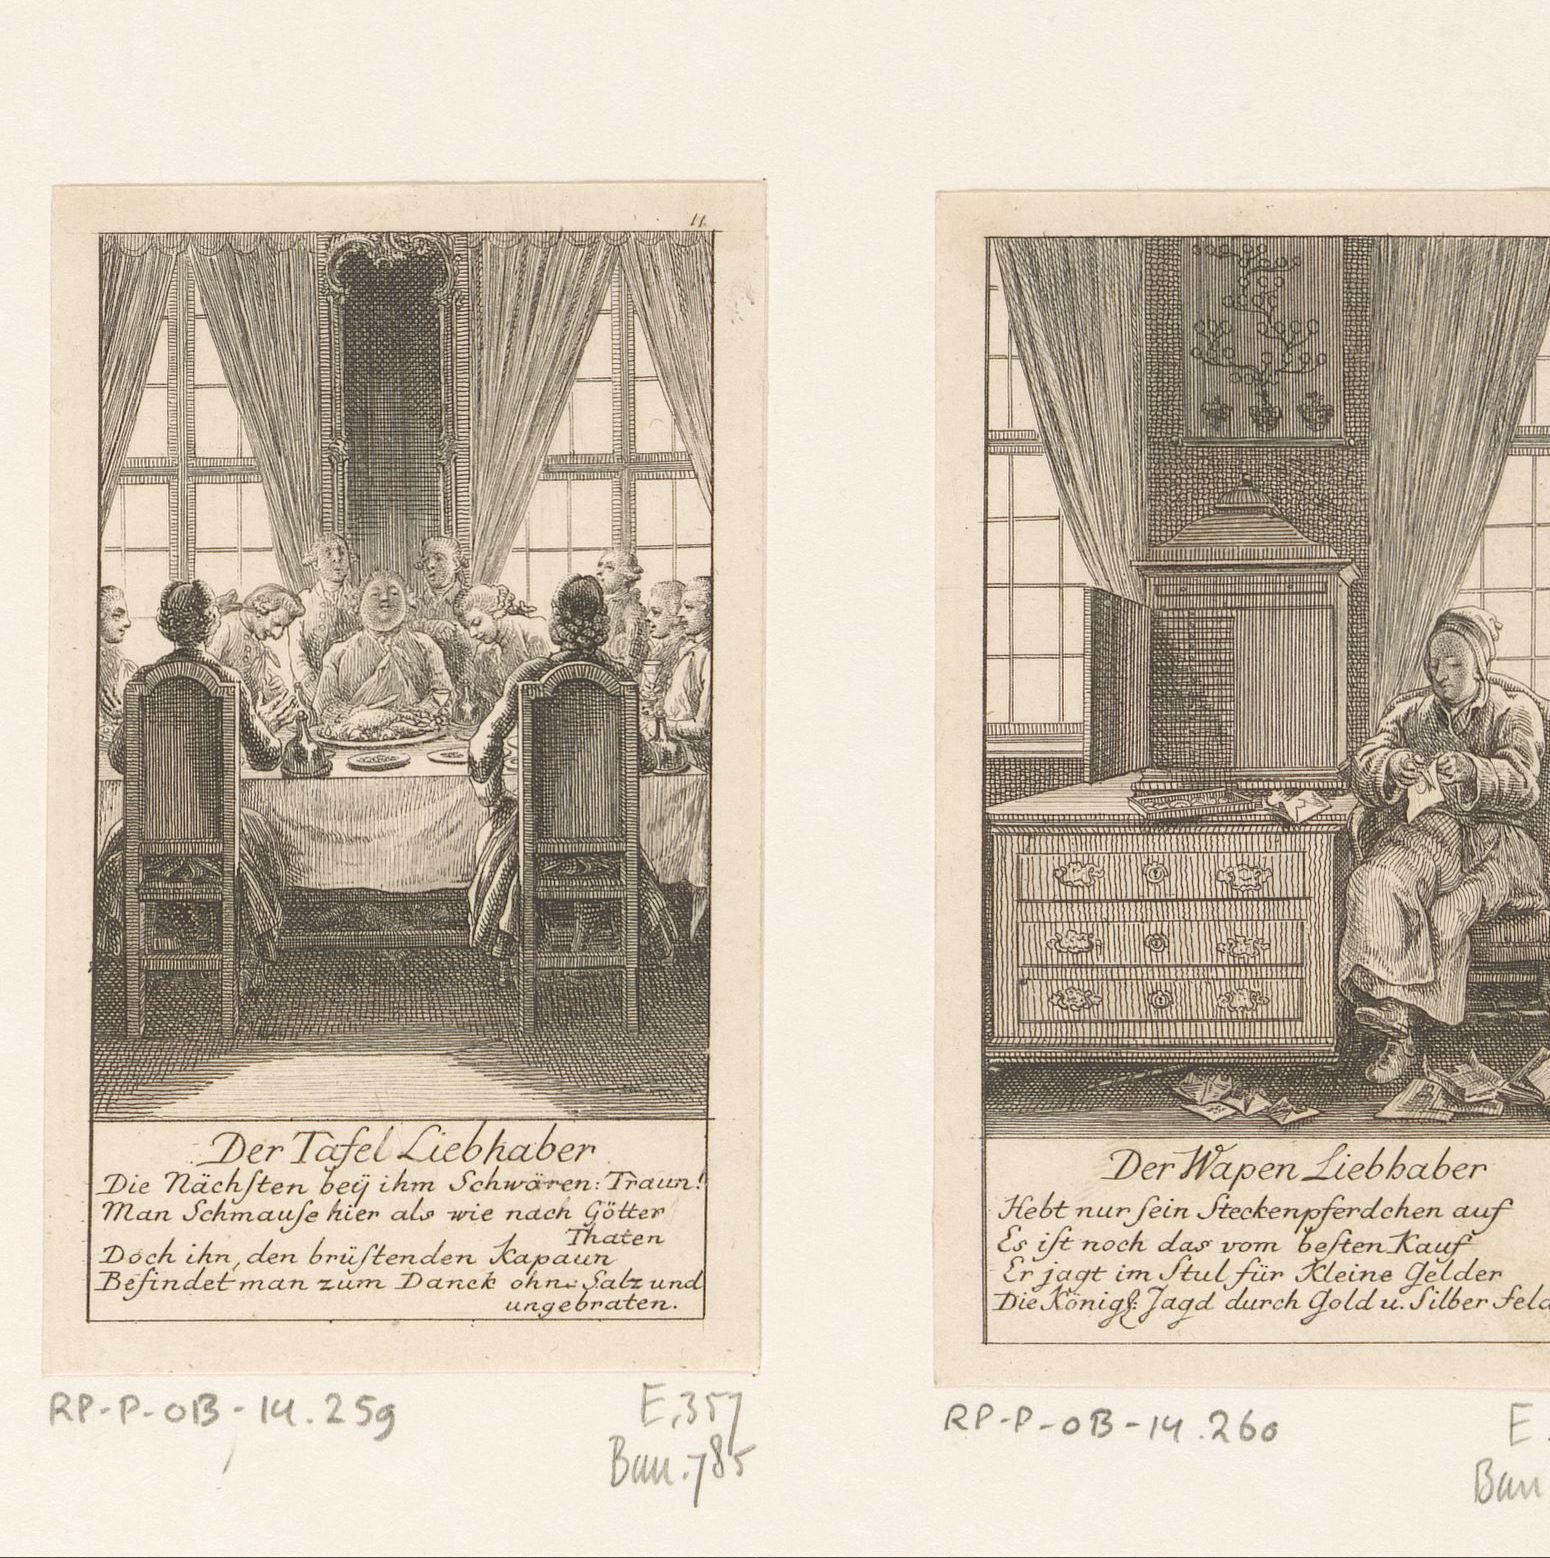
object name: print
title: Liefhebber van tafelen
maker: daniel nikolaus chodowiecki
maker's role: draughtsman, print maker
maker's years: 1726-1801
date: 1780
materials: paper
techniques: etching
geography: berlin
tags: evening meal, dinner, supper, eating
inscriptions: collector's mark: Lugt 2228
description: Prent gebruikt voor: Königl. Grossbr. Genealogischer Kalender auf das Jahr 1781. Lauenburg: J.G. Berenberg, [1780].